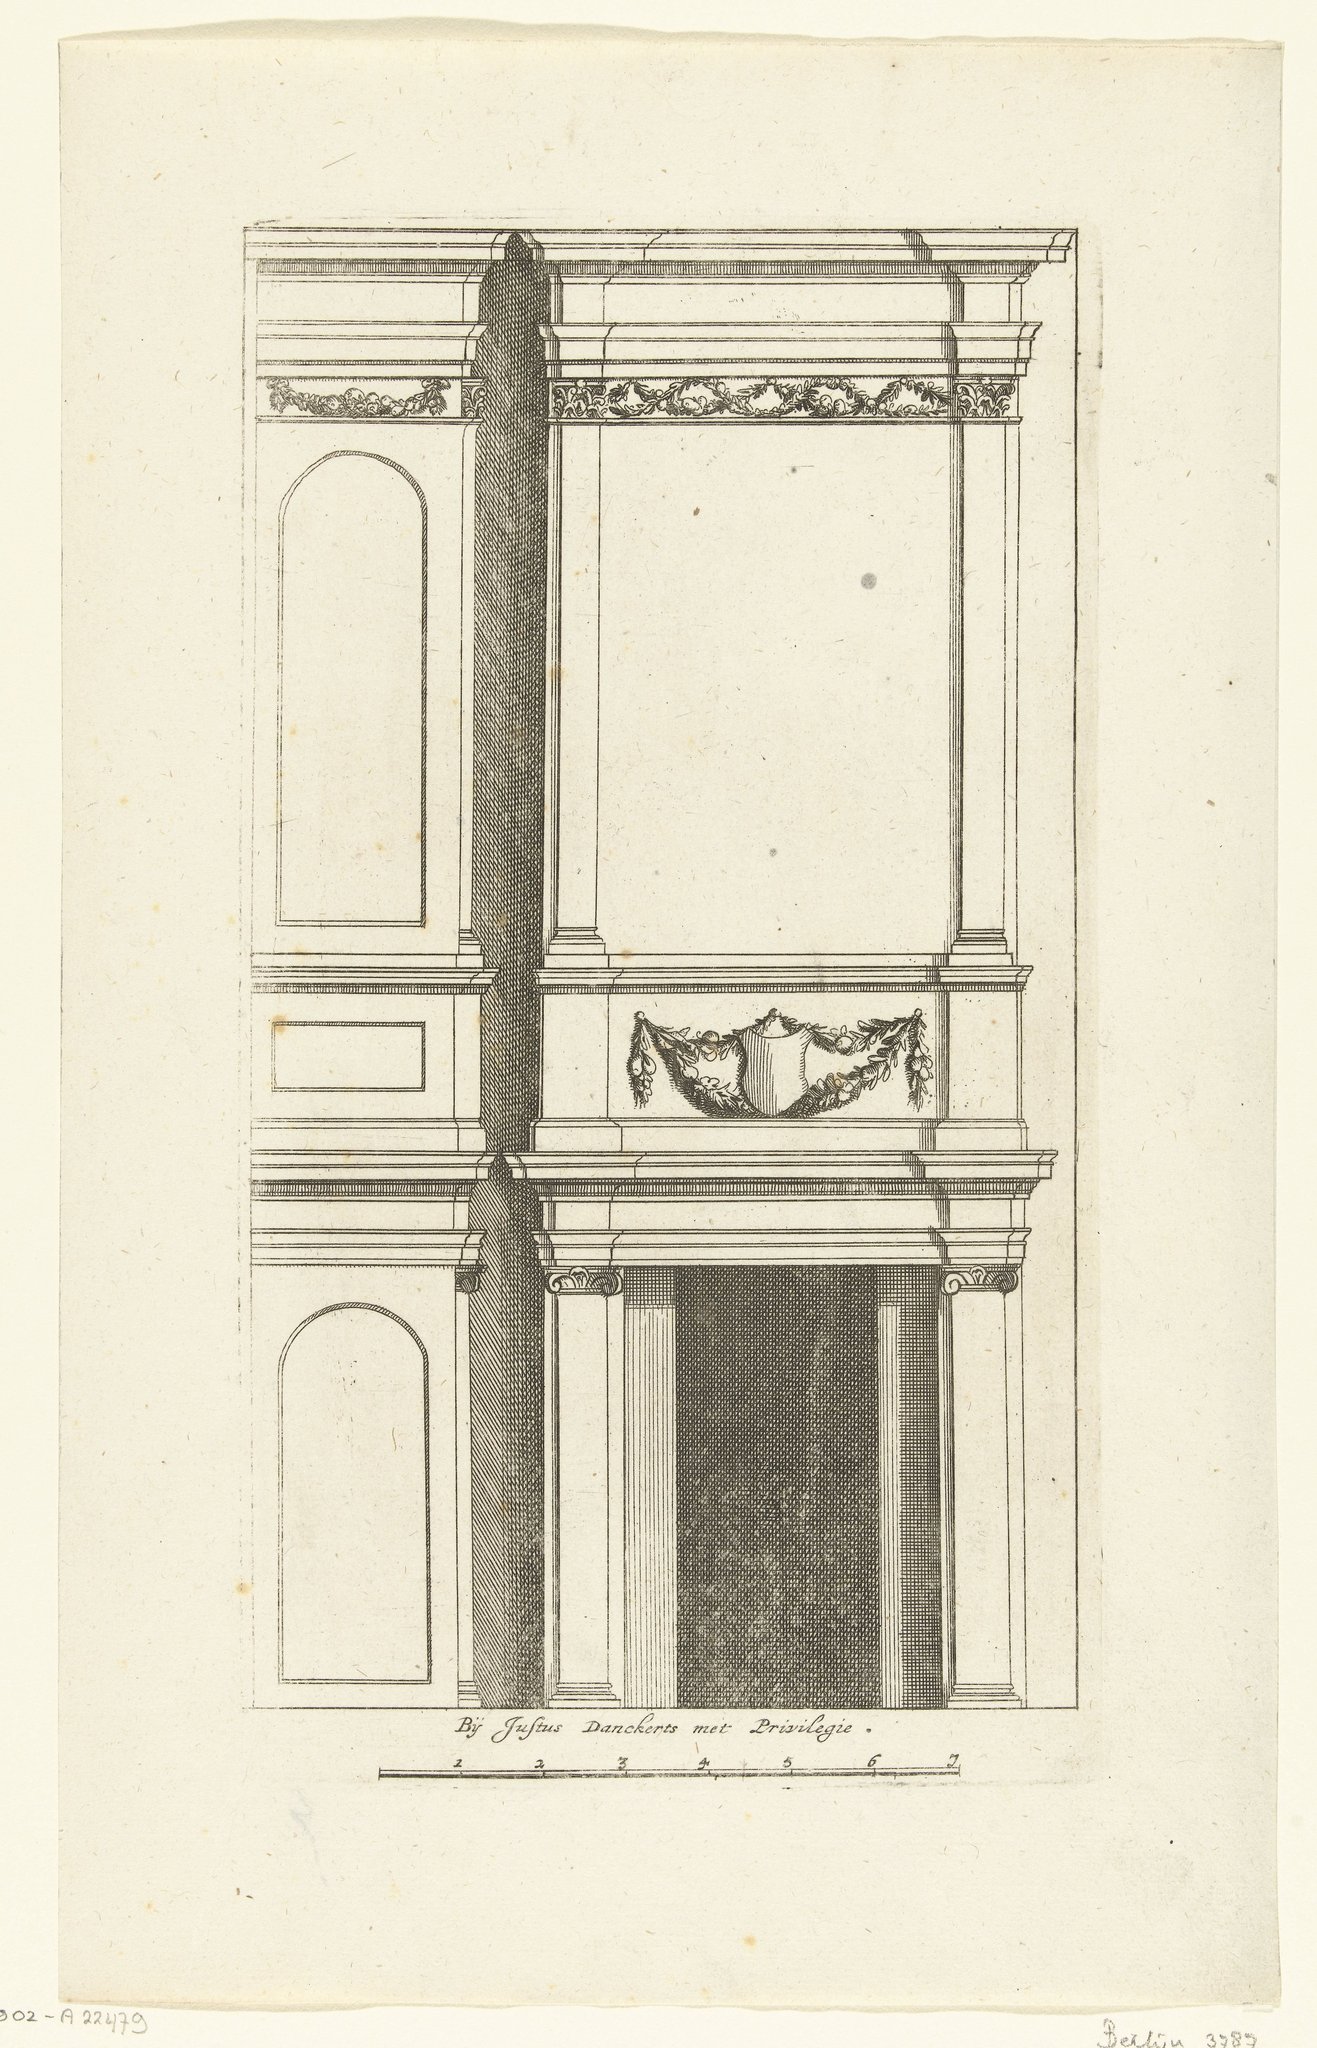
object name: ornament print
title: Onderboezems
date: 1675-1686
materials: paper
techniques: etching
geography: netherlands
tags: chimney-piece, mantelpiece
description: Zijopstand en vooropstand. Het tablet wordt gesteund door Ionische pilatsers.